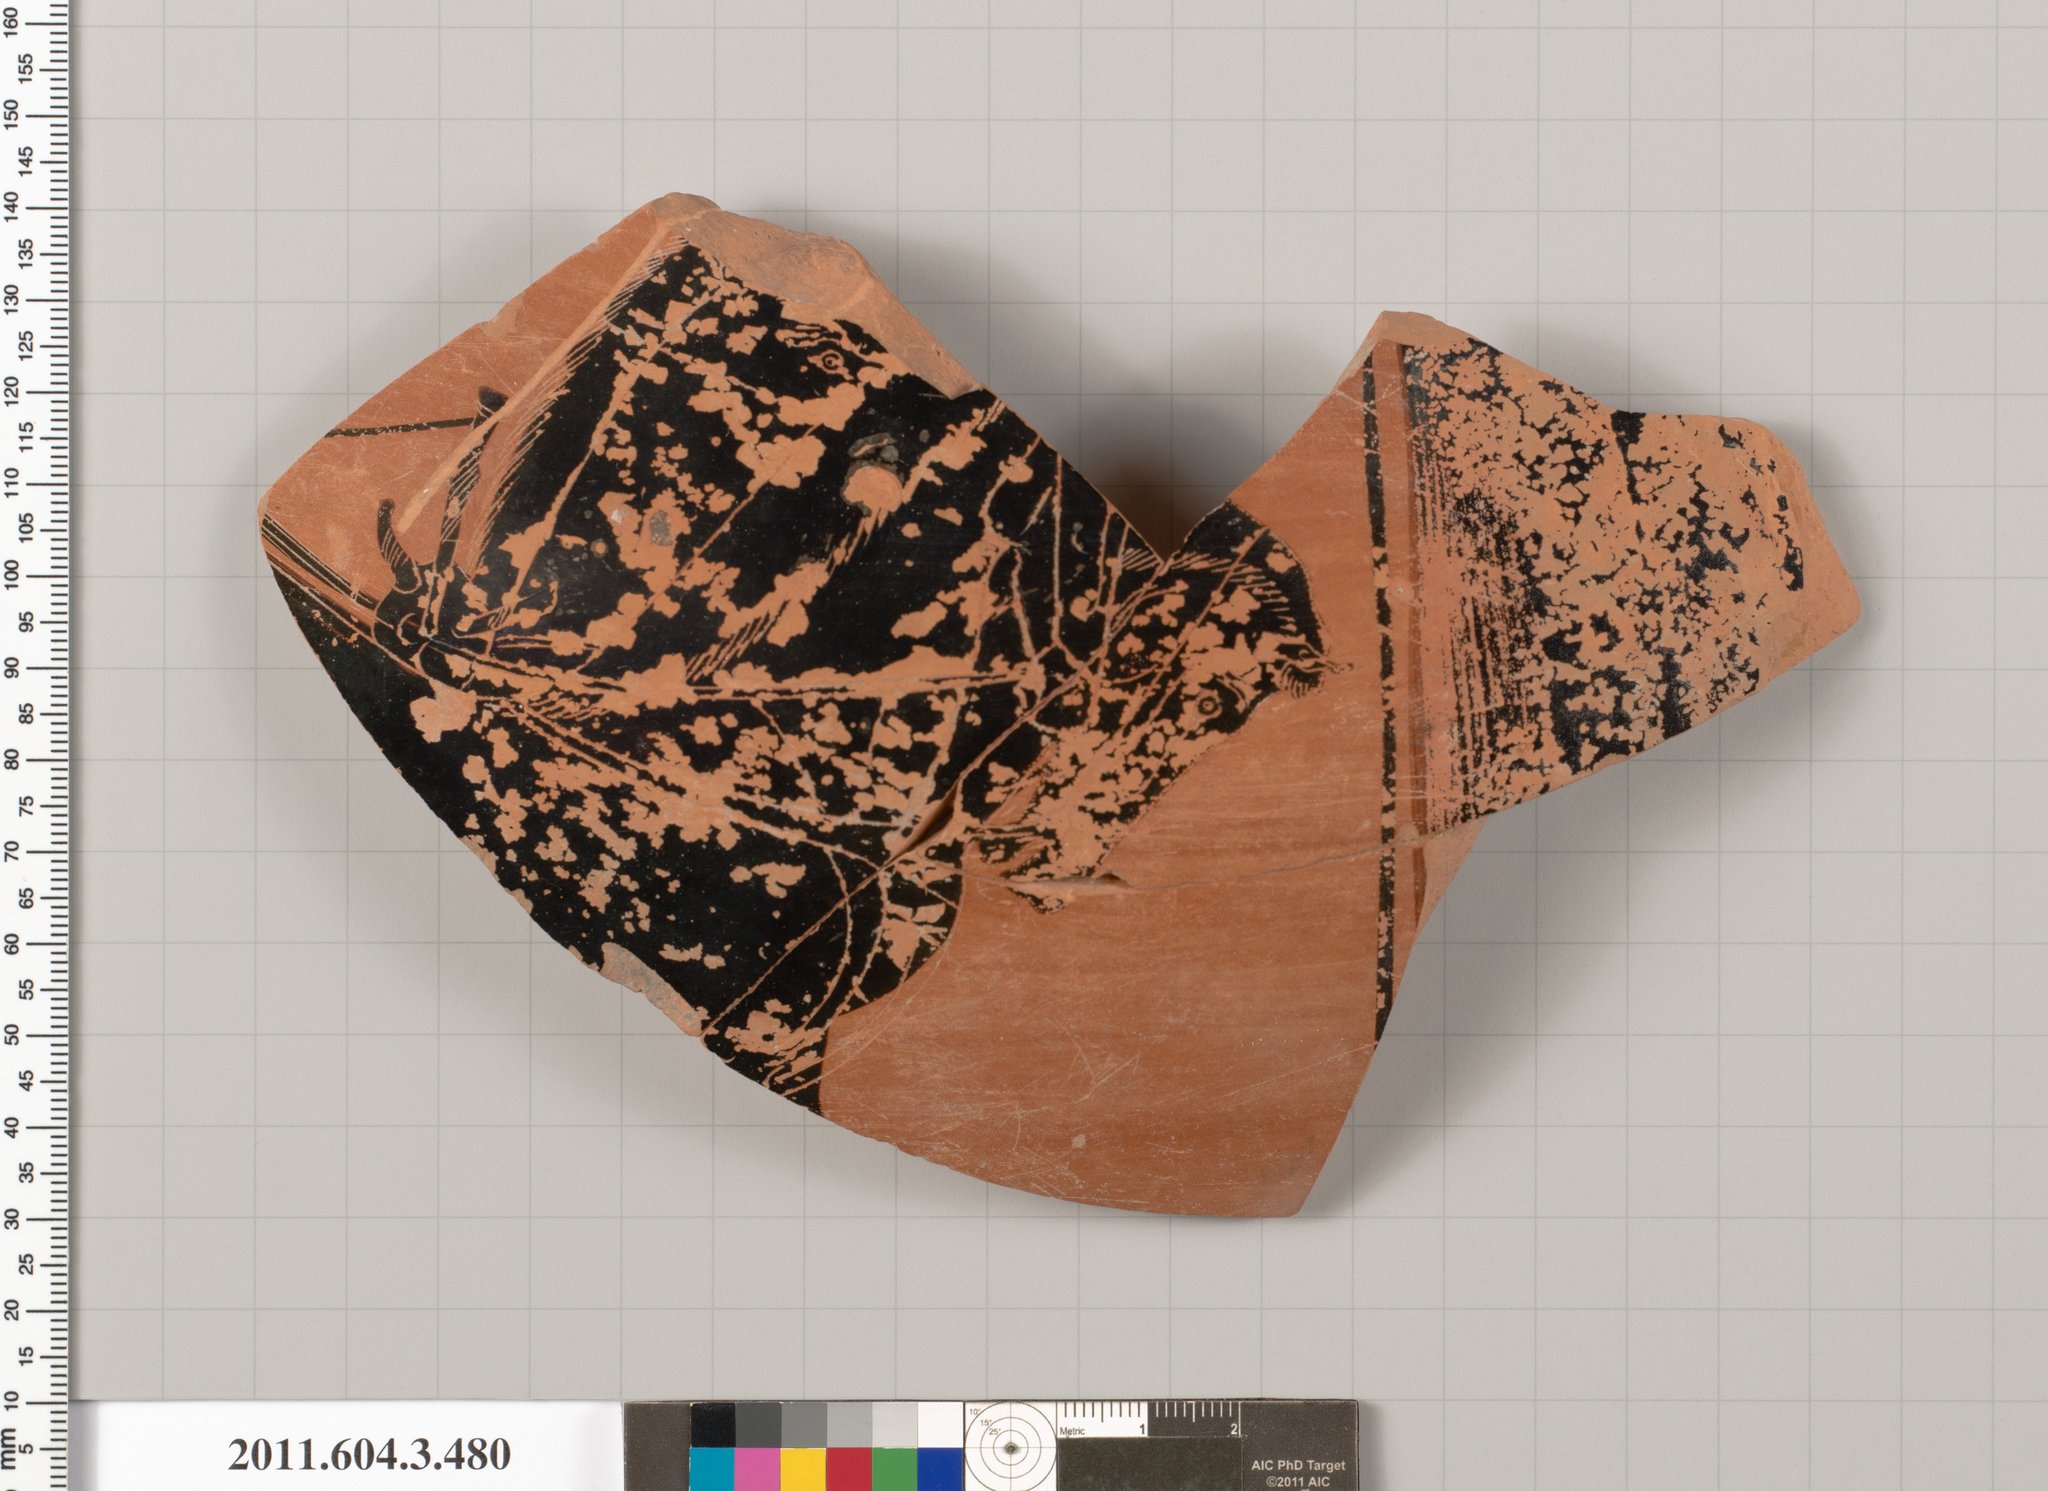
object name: neck amphora fragment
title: Terracotta fragment of a neck-amphora of Panathenaic shape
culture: greek, attic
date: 525-501 BCE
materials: terracotta